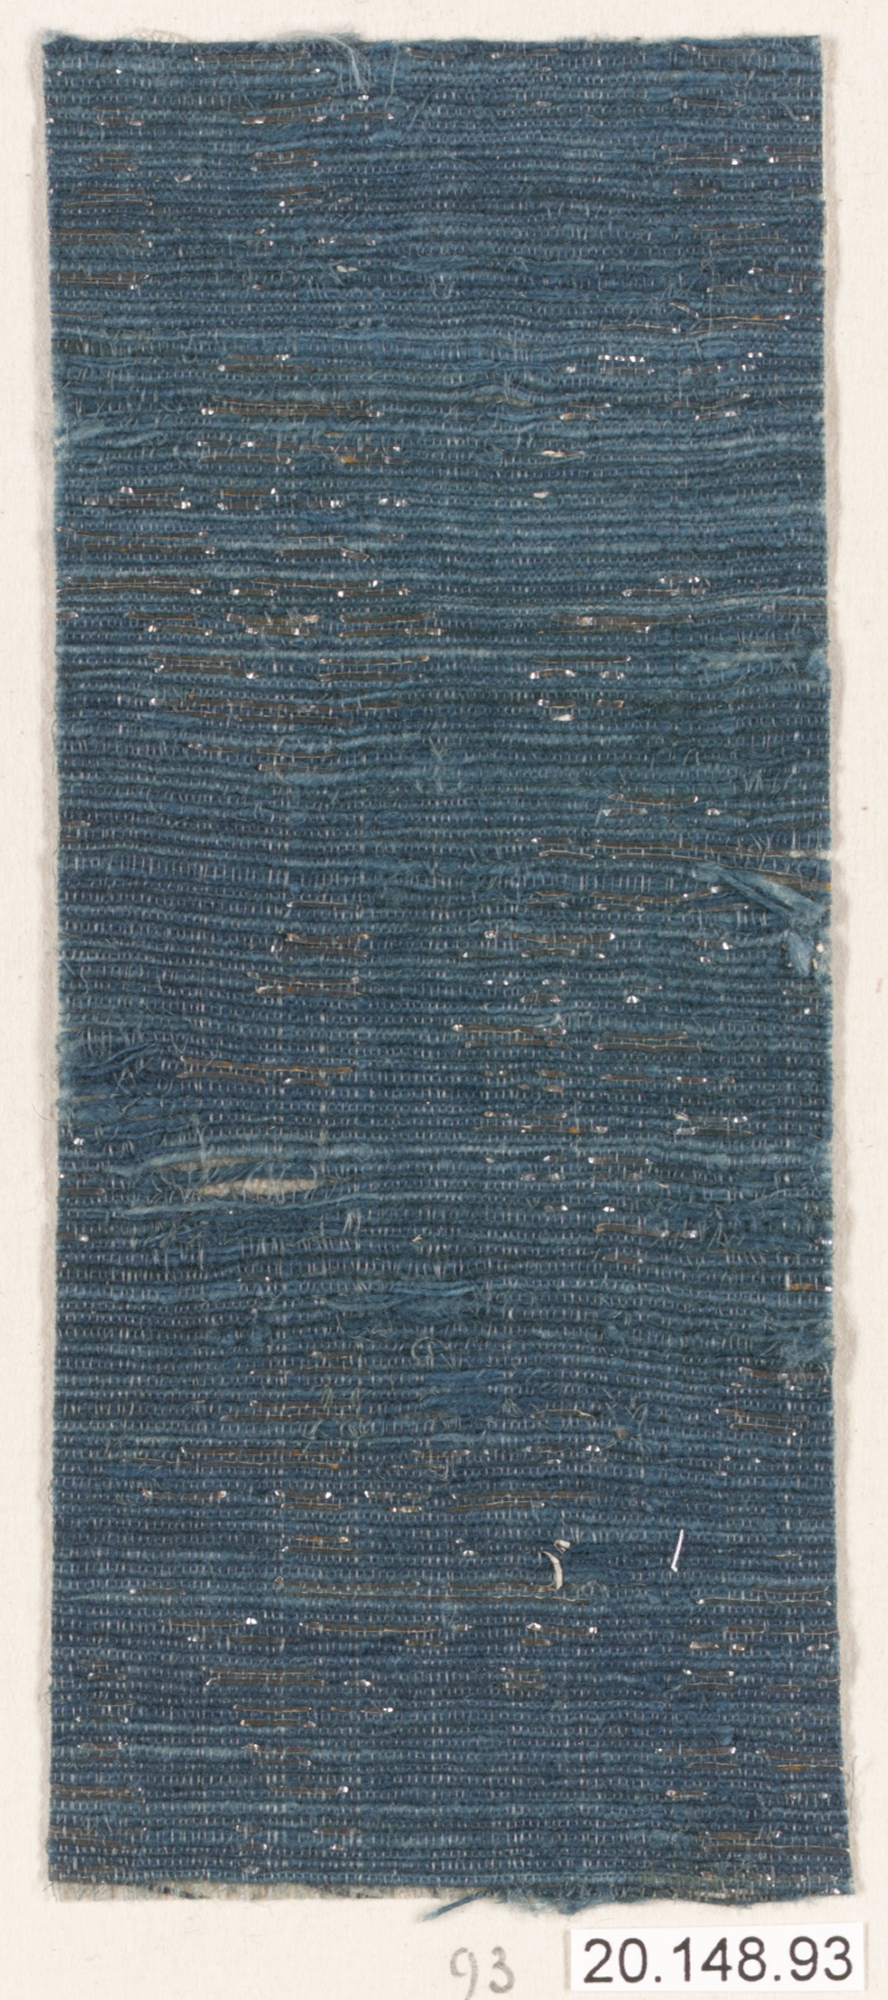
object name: piece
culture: japanese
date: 1601-1700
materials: silk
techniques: compound weave